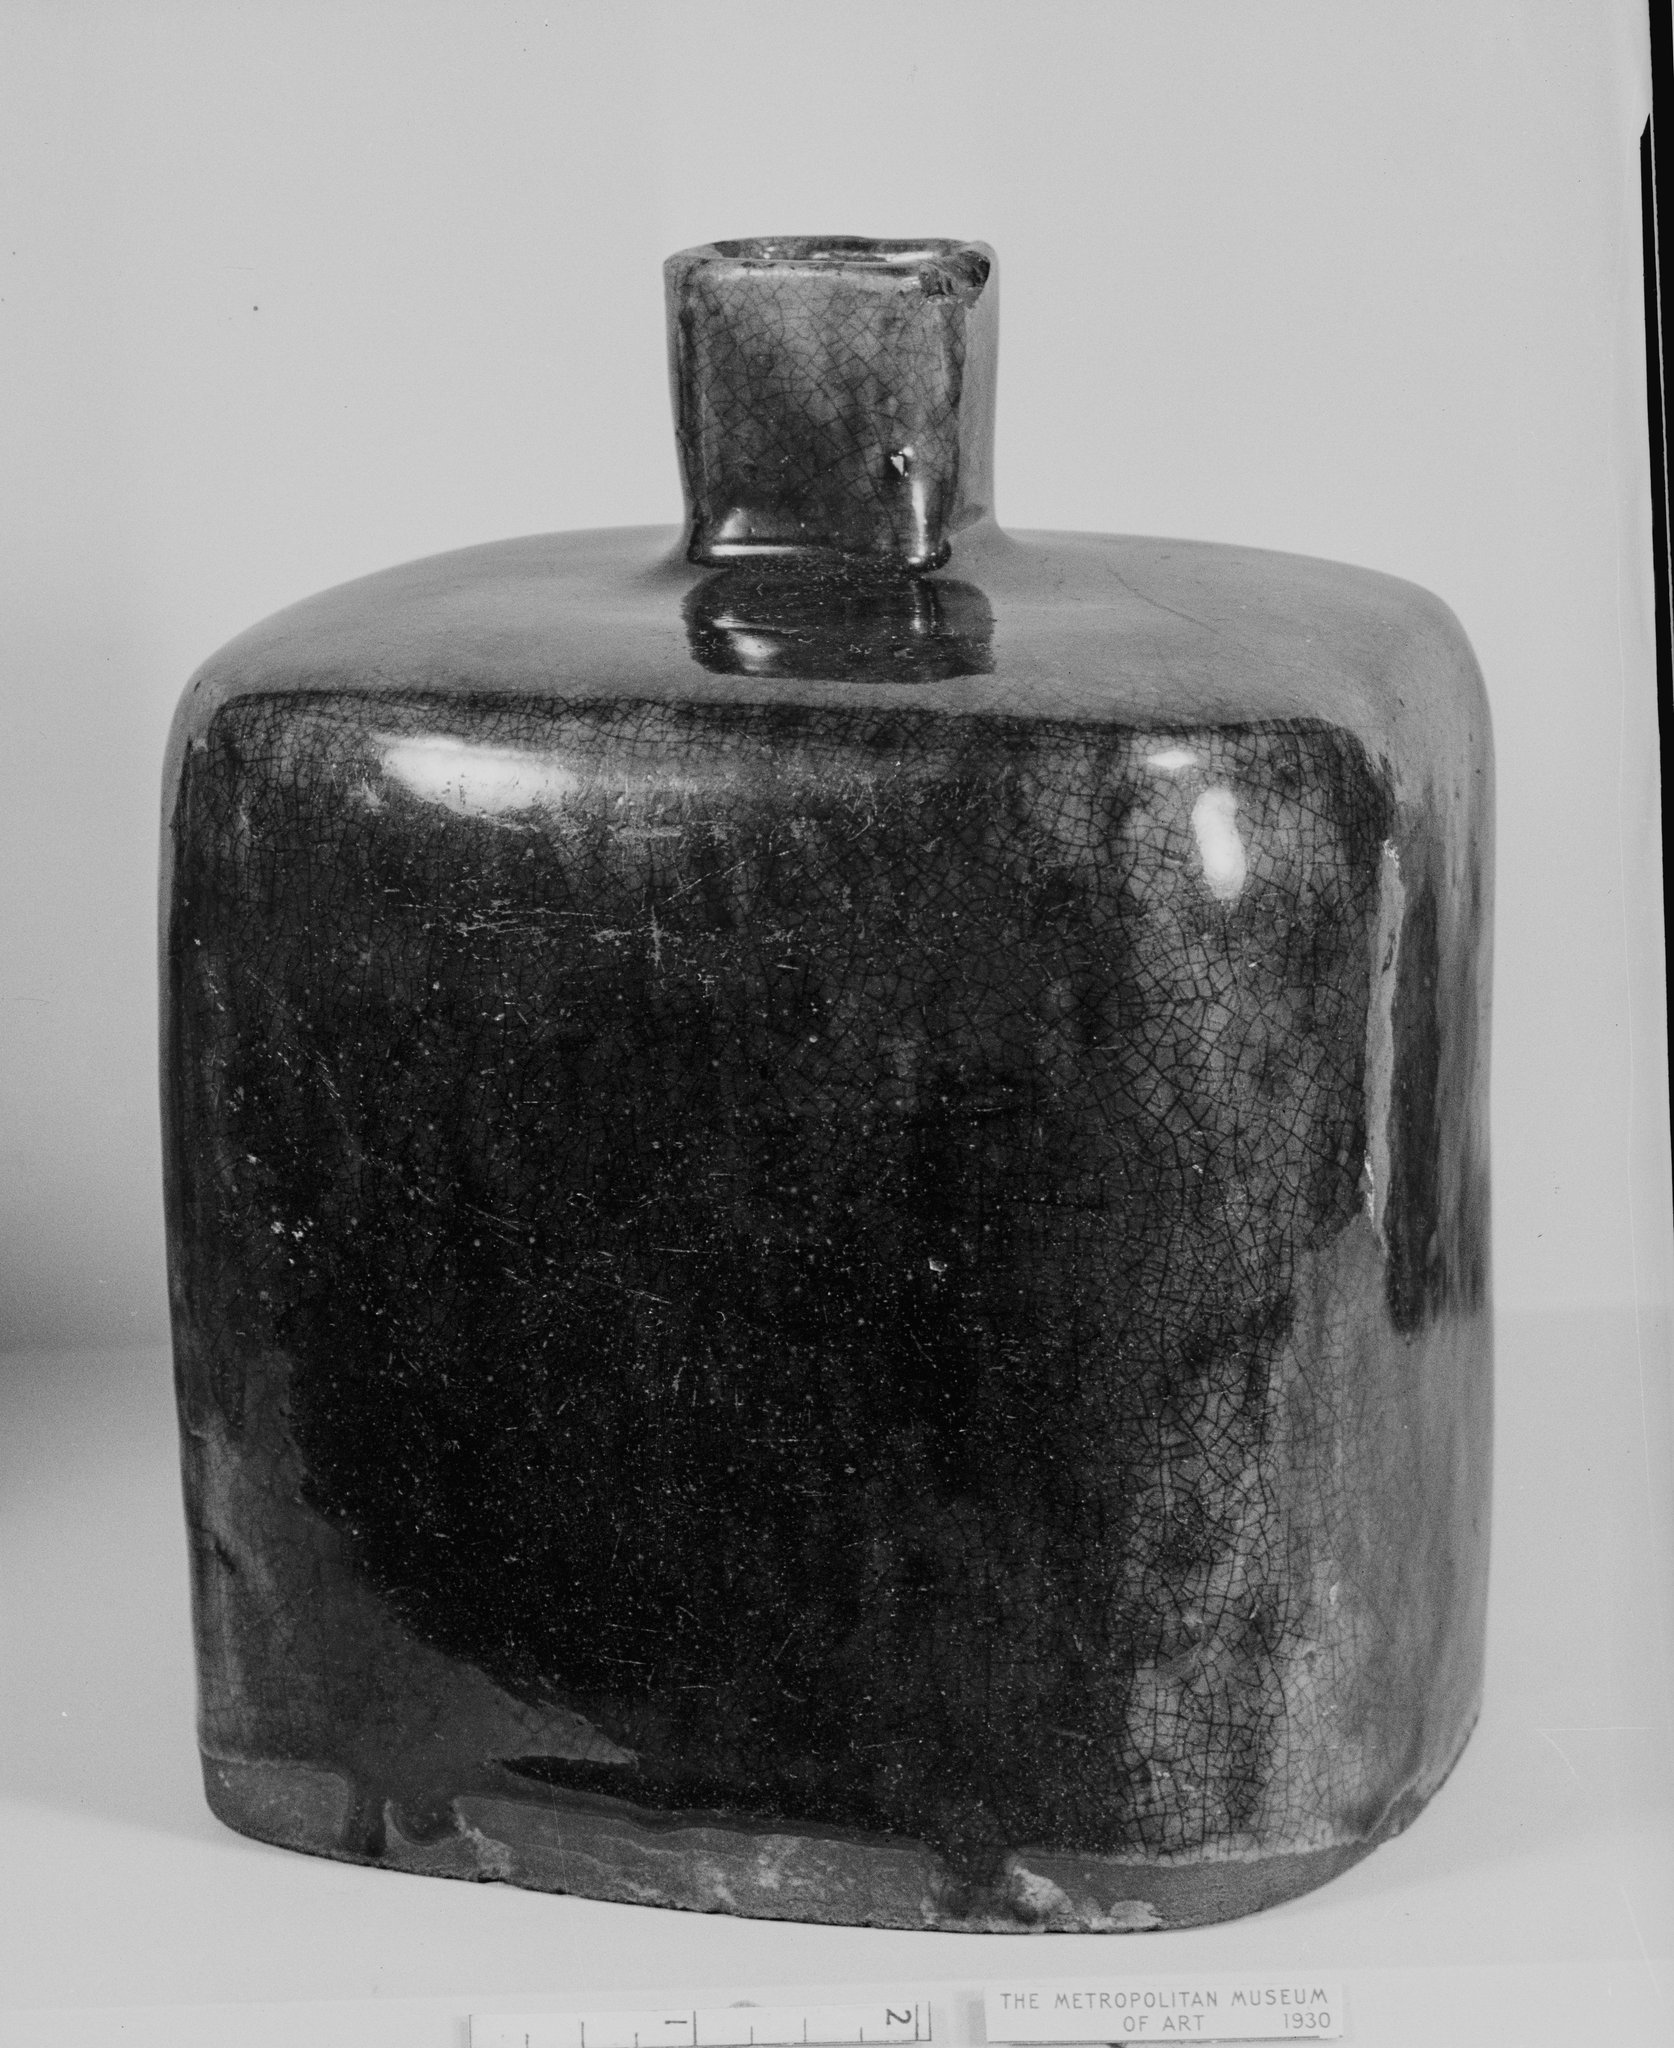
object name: bottle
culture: japanese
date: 1701-1800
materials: clay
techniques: overglaze, underglaze